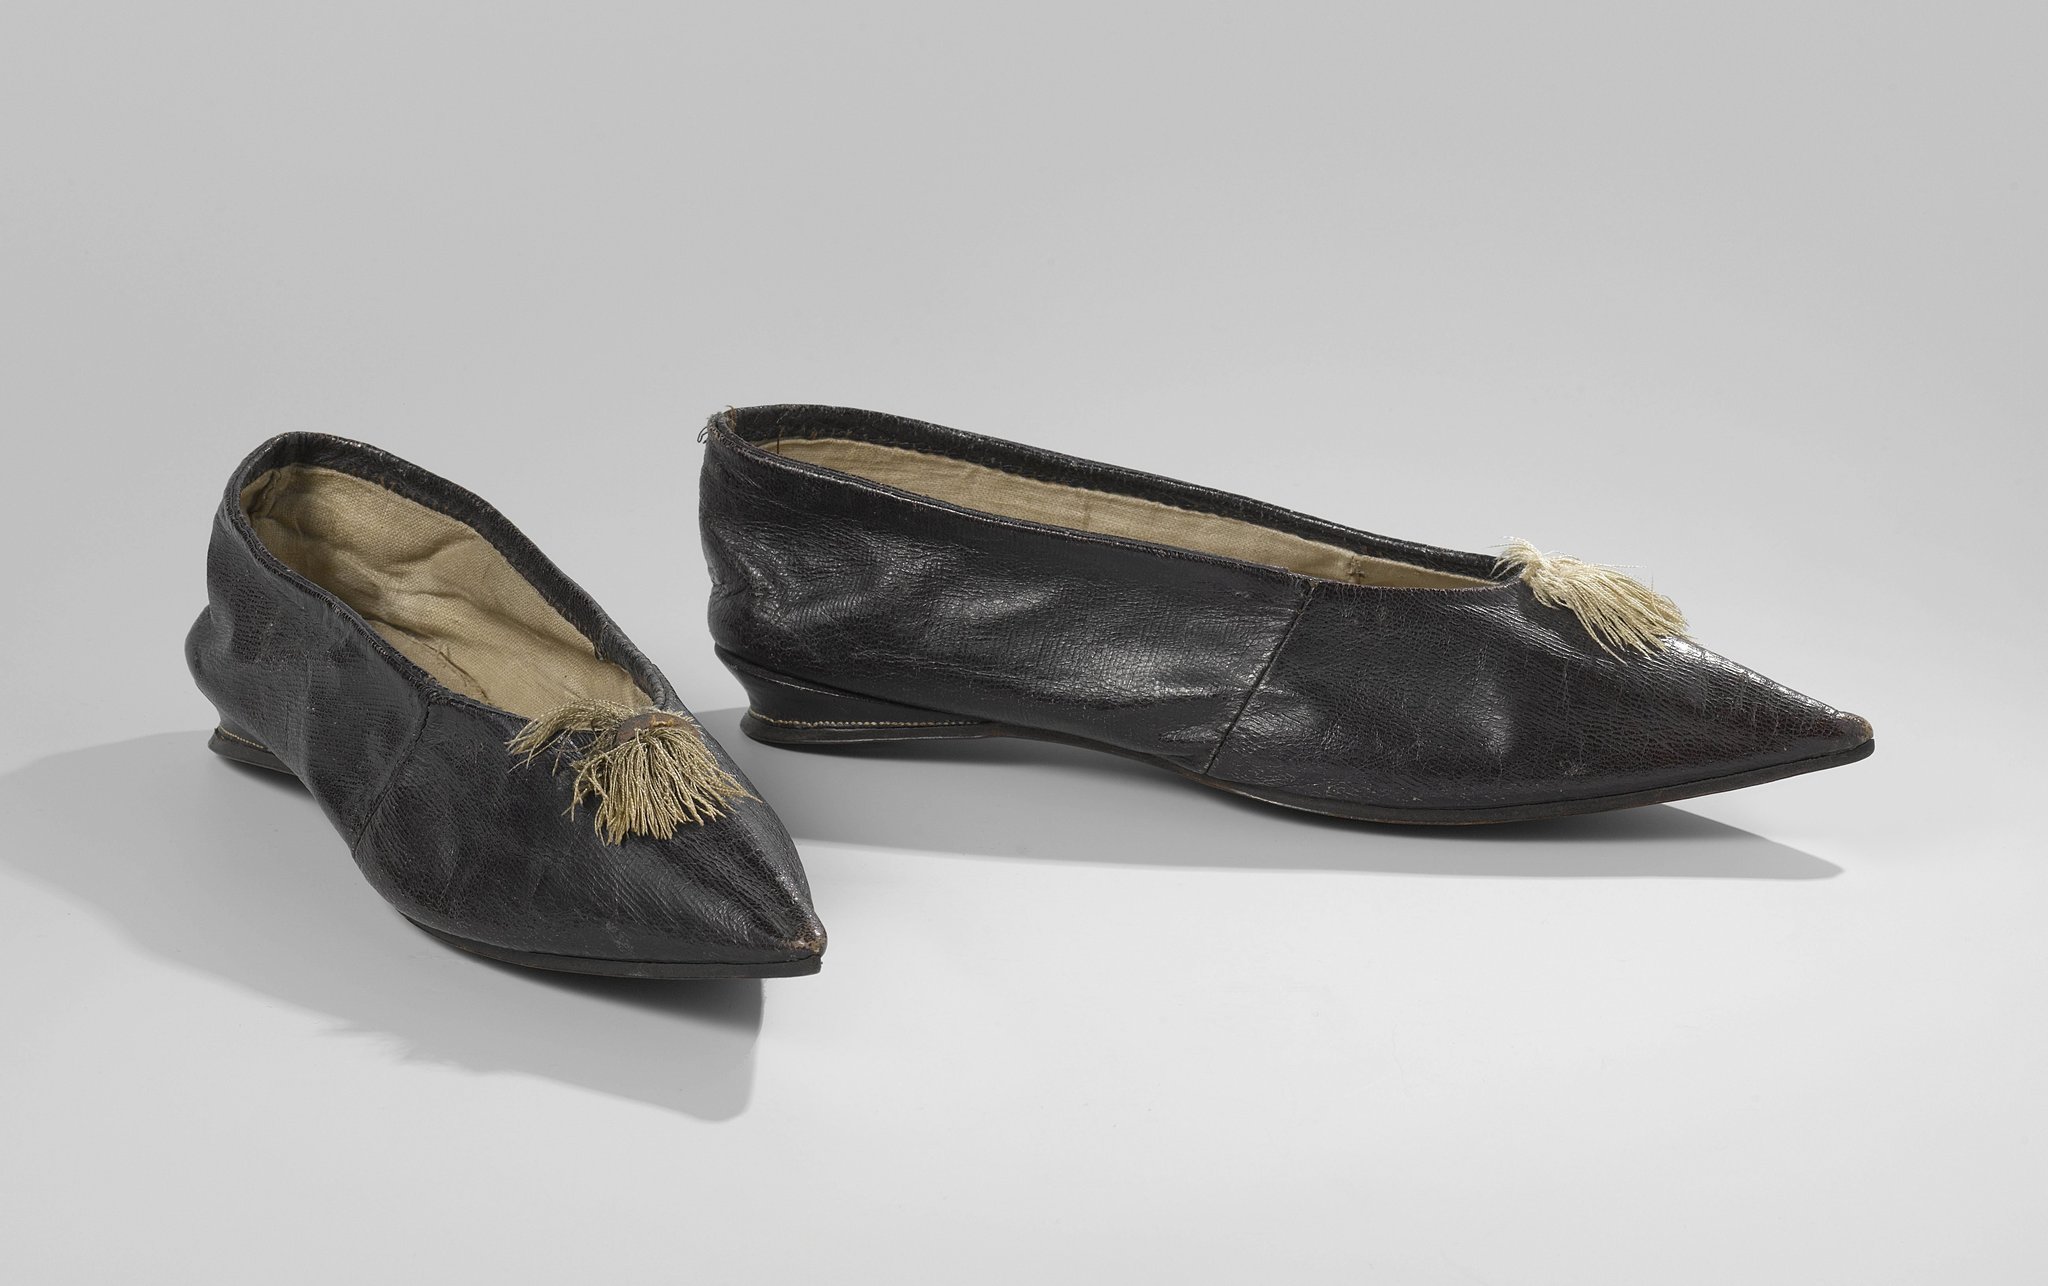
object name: shoe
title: Pair of ladies’ shoes with a wedge heel and a tassel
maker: Anonymous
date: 1800-1810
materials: leather, linen, silk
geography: netherlands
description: In the 1780s heels reached an unprecedented height, whereby women teetered uncomfortably on their forefeet. In the period after 1790, under the influence of the French Revolution, fashion became simpler, and flat shoes became stylish. Fabric shoes increasingly gave way to ones made of leather. Over the course of time, the toes became more pointed.